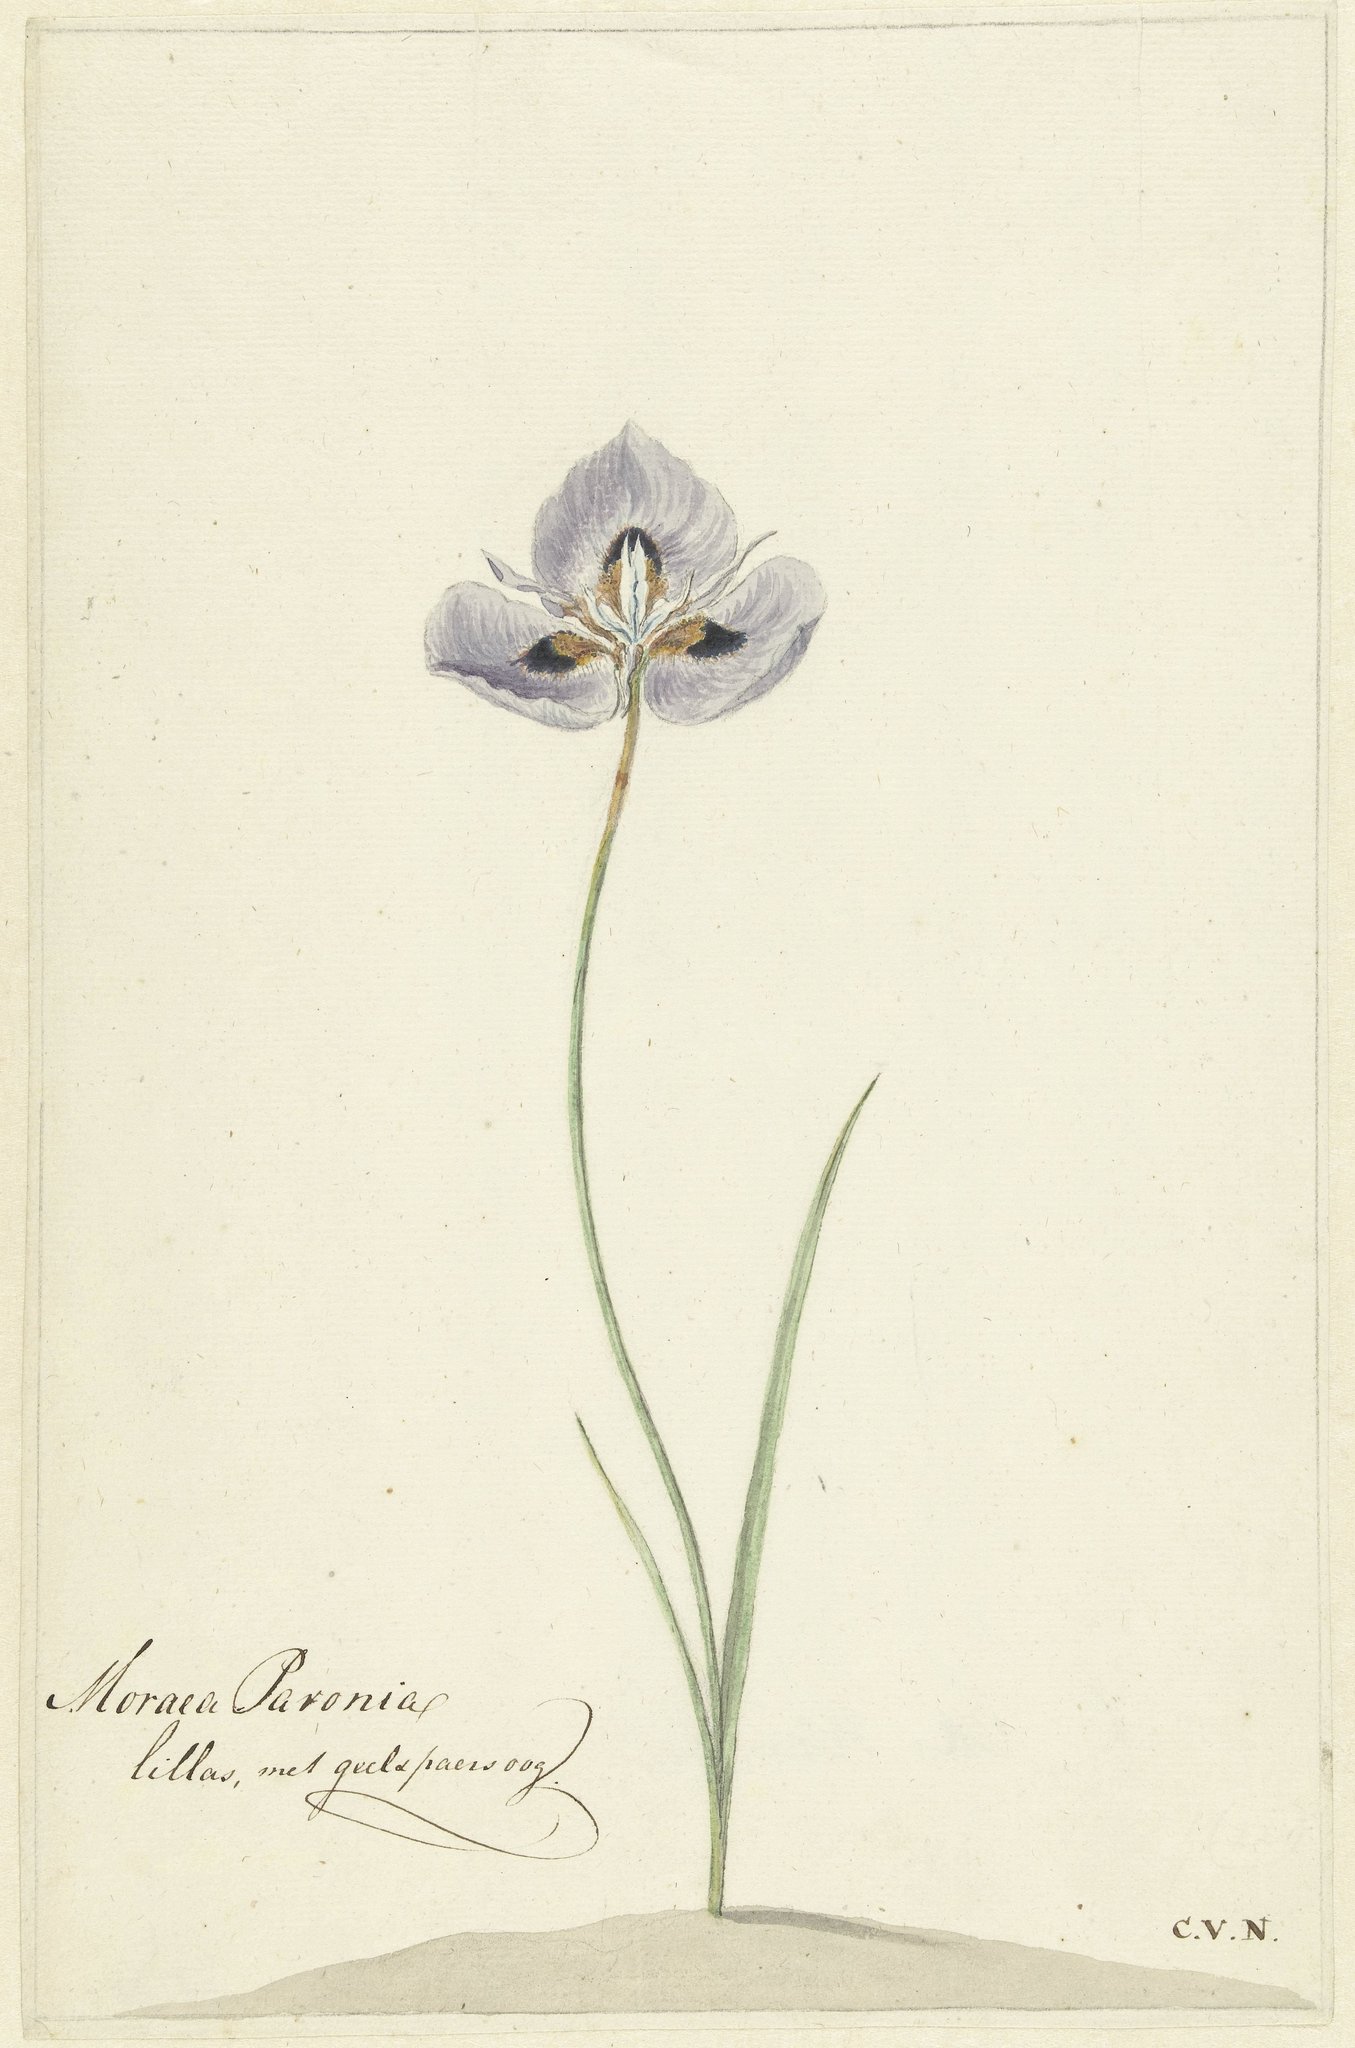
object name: drawing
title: Iris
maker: cornelis van noorde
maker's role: draughtsman, print maker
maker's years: 1731-1795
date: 1741-1795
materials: chalk, paper, watercolor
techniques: brush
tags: flowers: iris